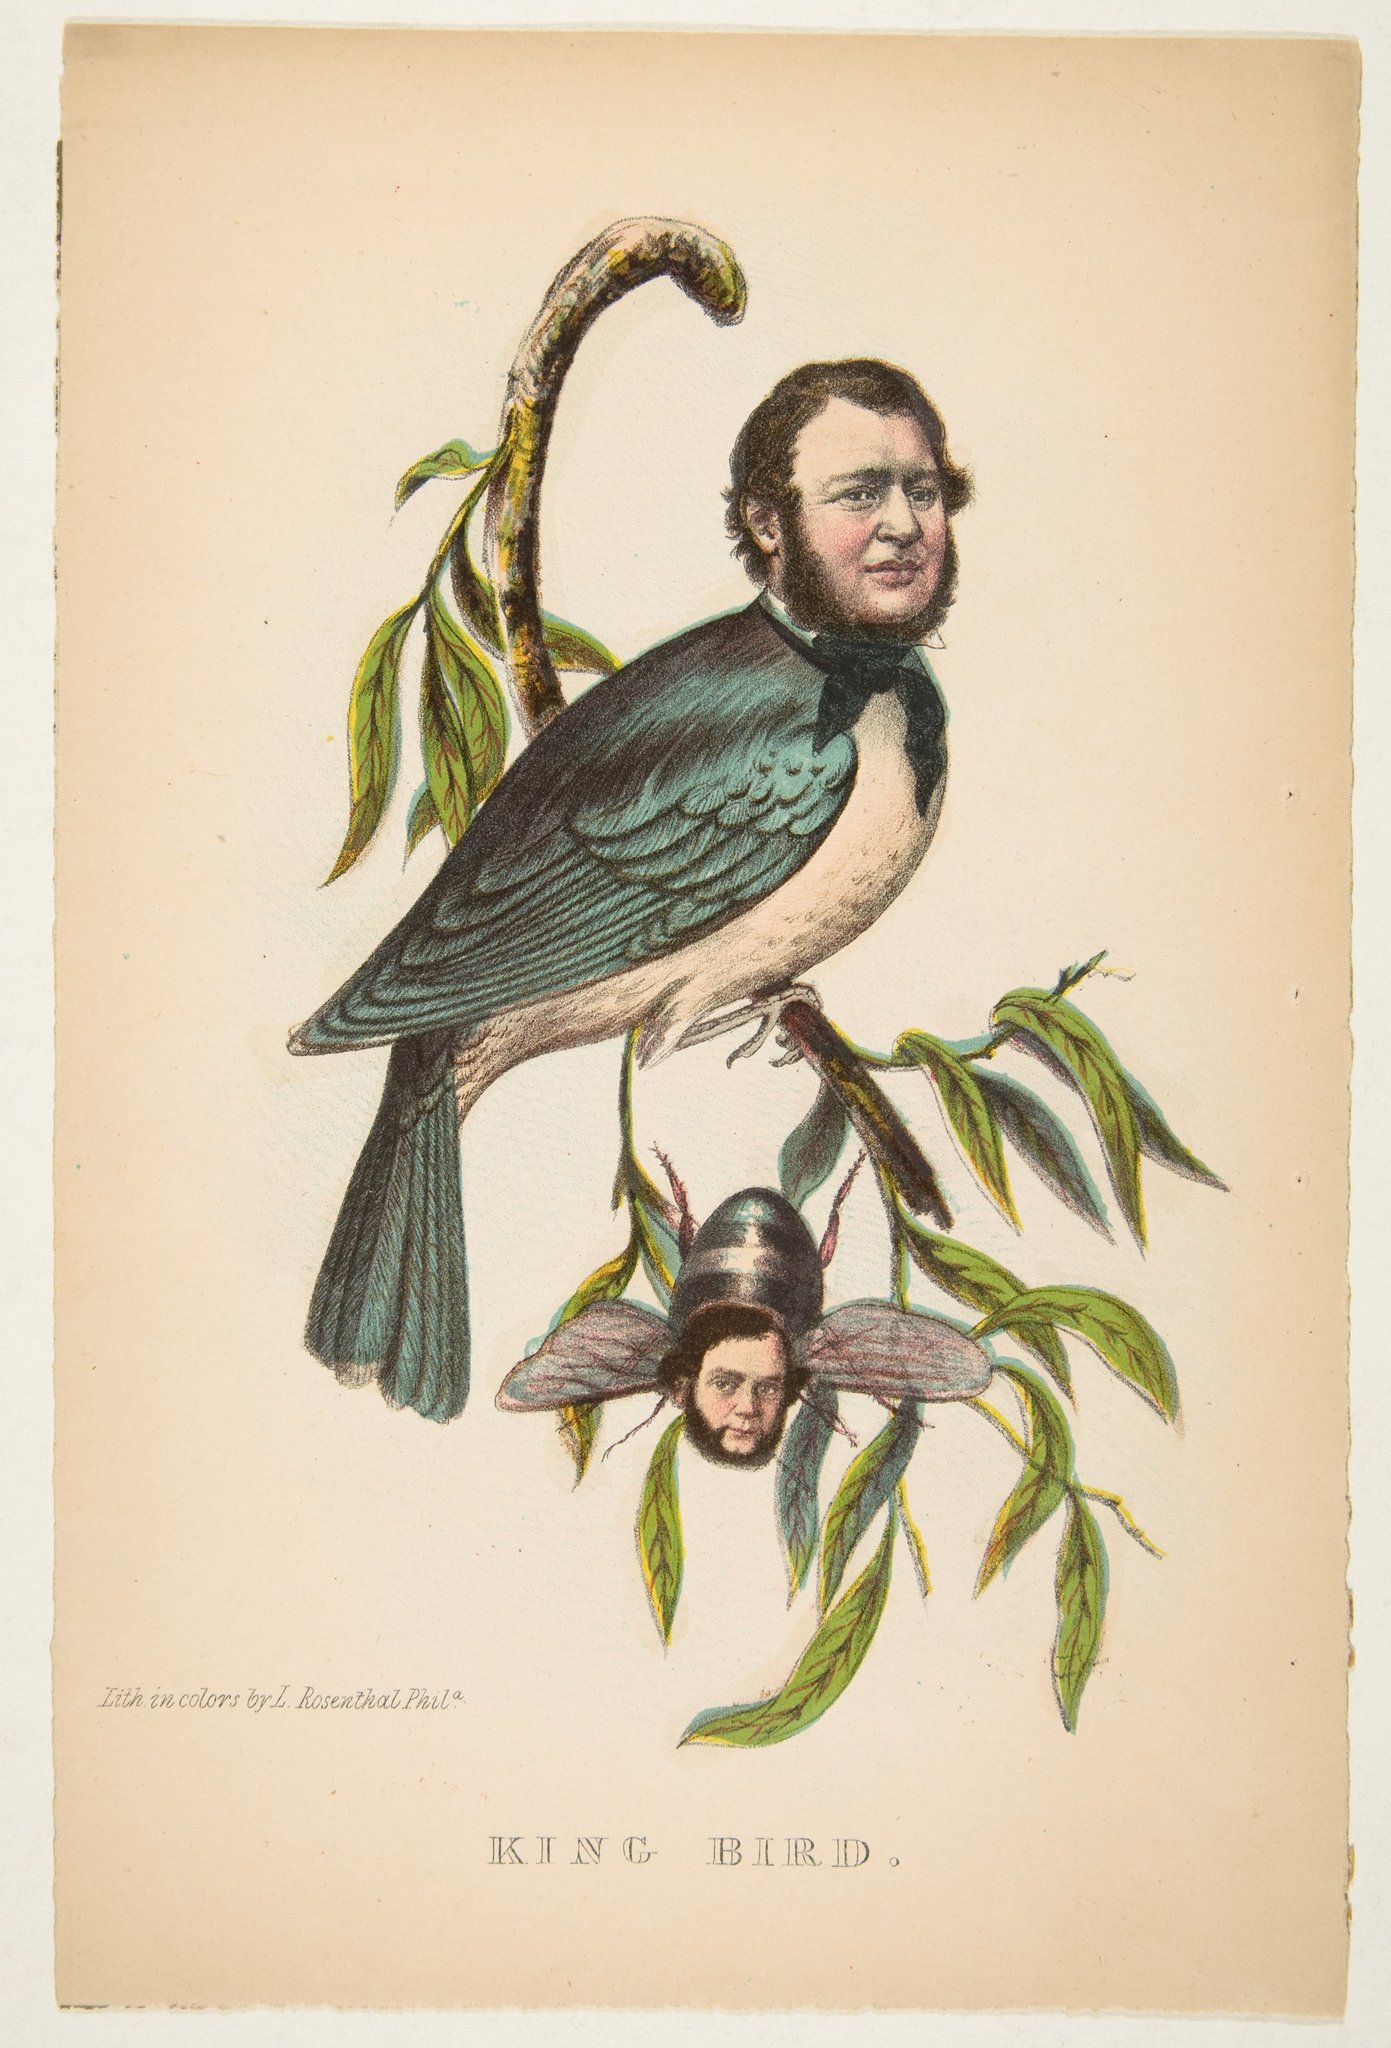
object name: print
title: King Bird (Robert P. King and Alexander Baird), from "The Comic Natural History of the Human Race"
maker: henry louis stephens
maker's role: artist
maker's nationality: american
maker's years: 1824-1882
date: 1851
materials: watercolor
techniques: lithograph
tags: satire